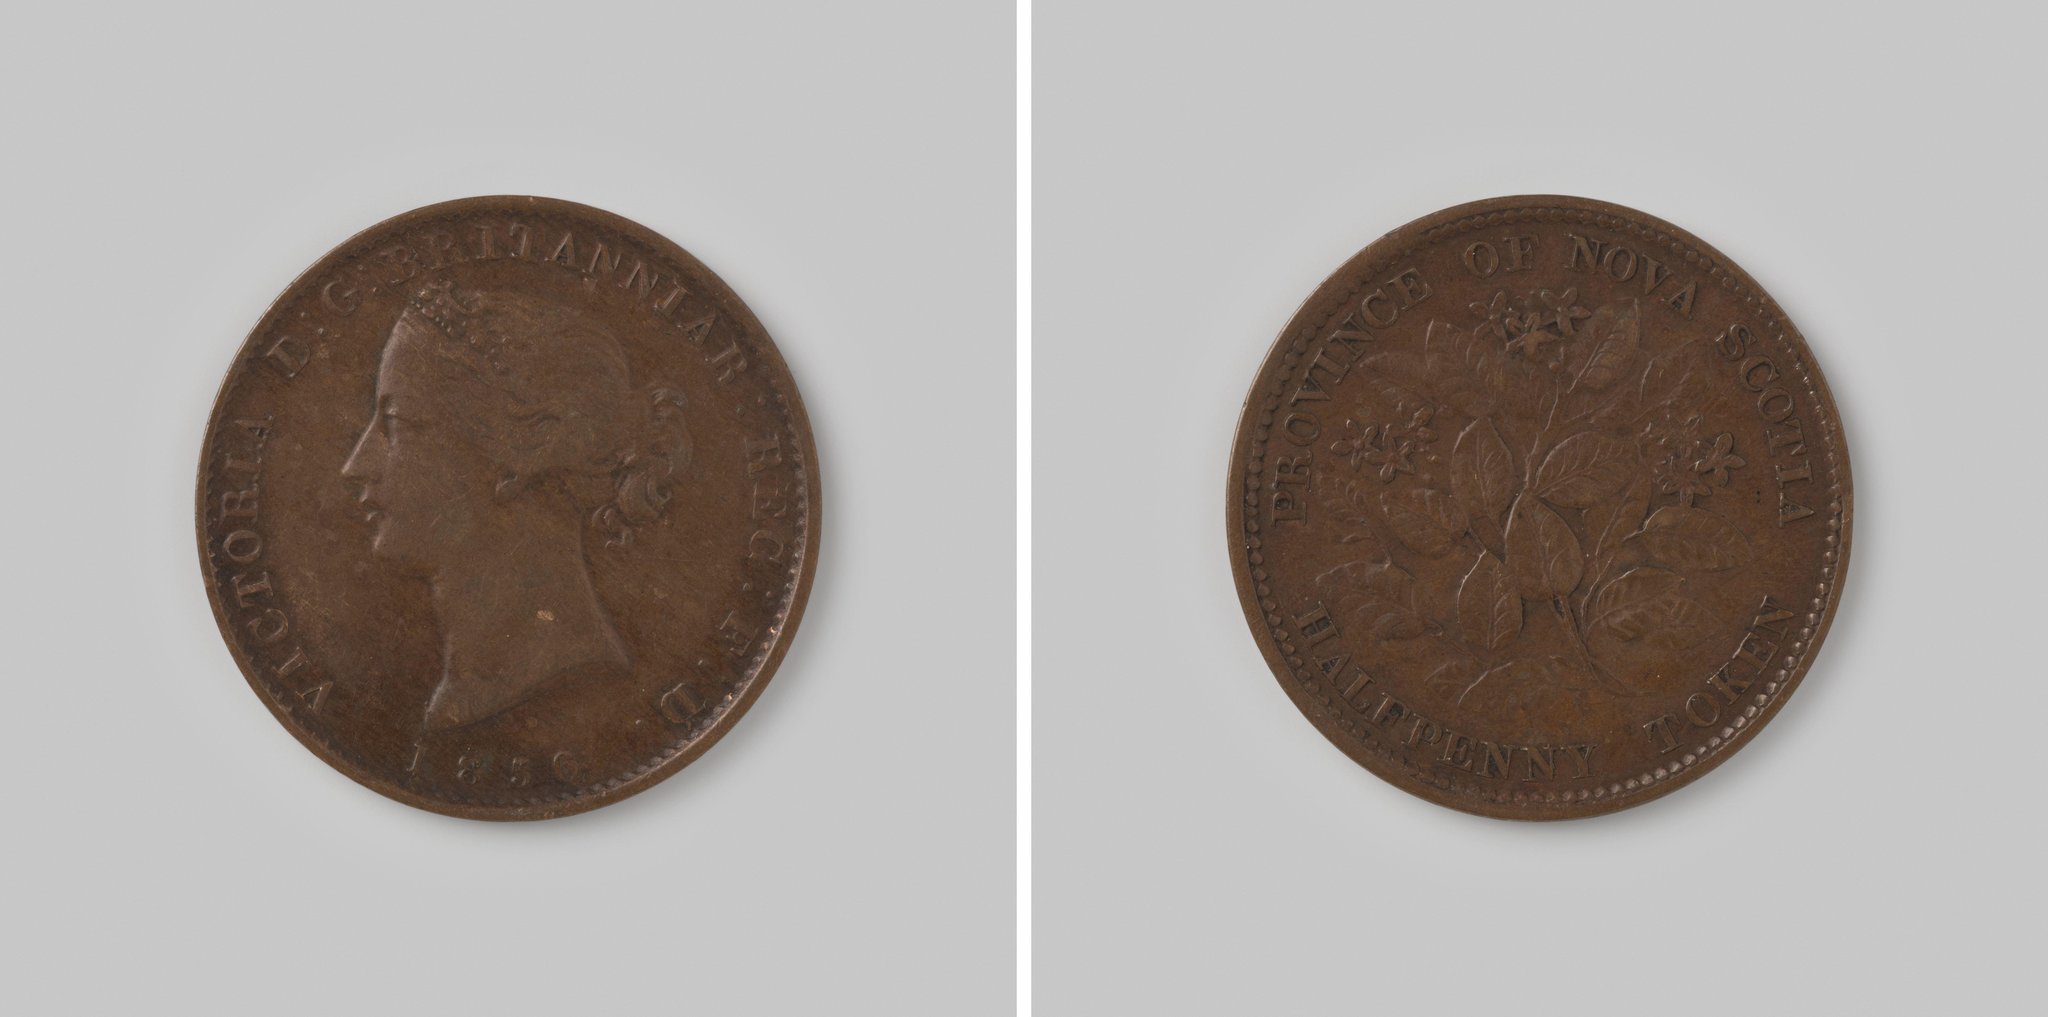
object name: halve penny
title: Nova Scotia, Canada, ½ penny token, 1856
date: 1856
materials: bronze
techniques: striking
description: Bronzen particuliere munt. Voorzijde: gekroond hoofd van vorstin Victoria naar links. Daaronder jaartal. Keerzxijde: plantentakken en bloemen ineen gestrengeld. Als omschrift waarde- en lands-aanduiding. Gladde rand.